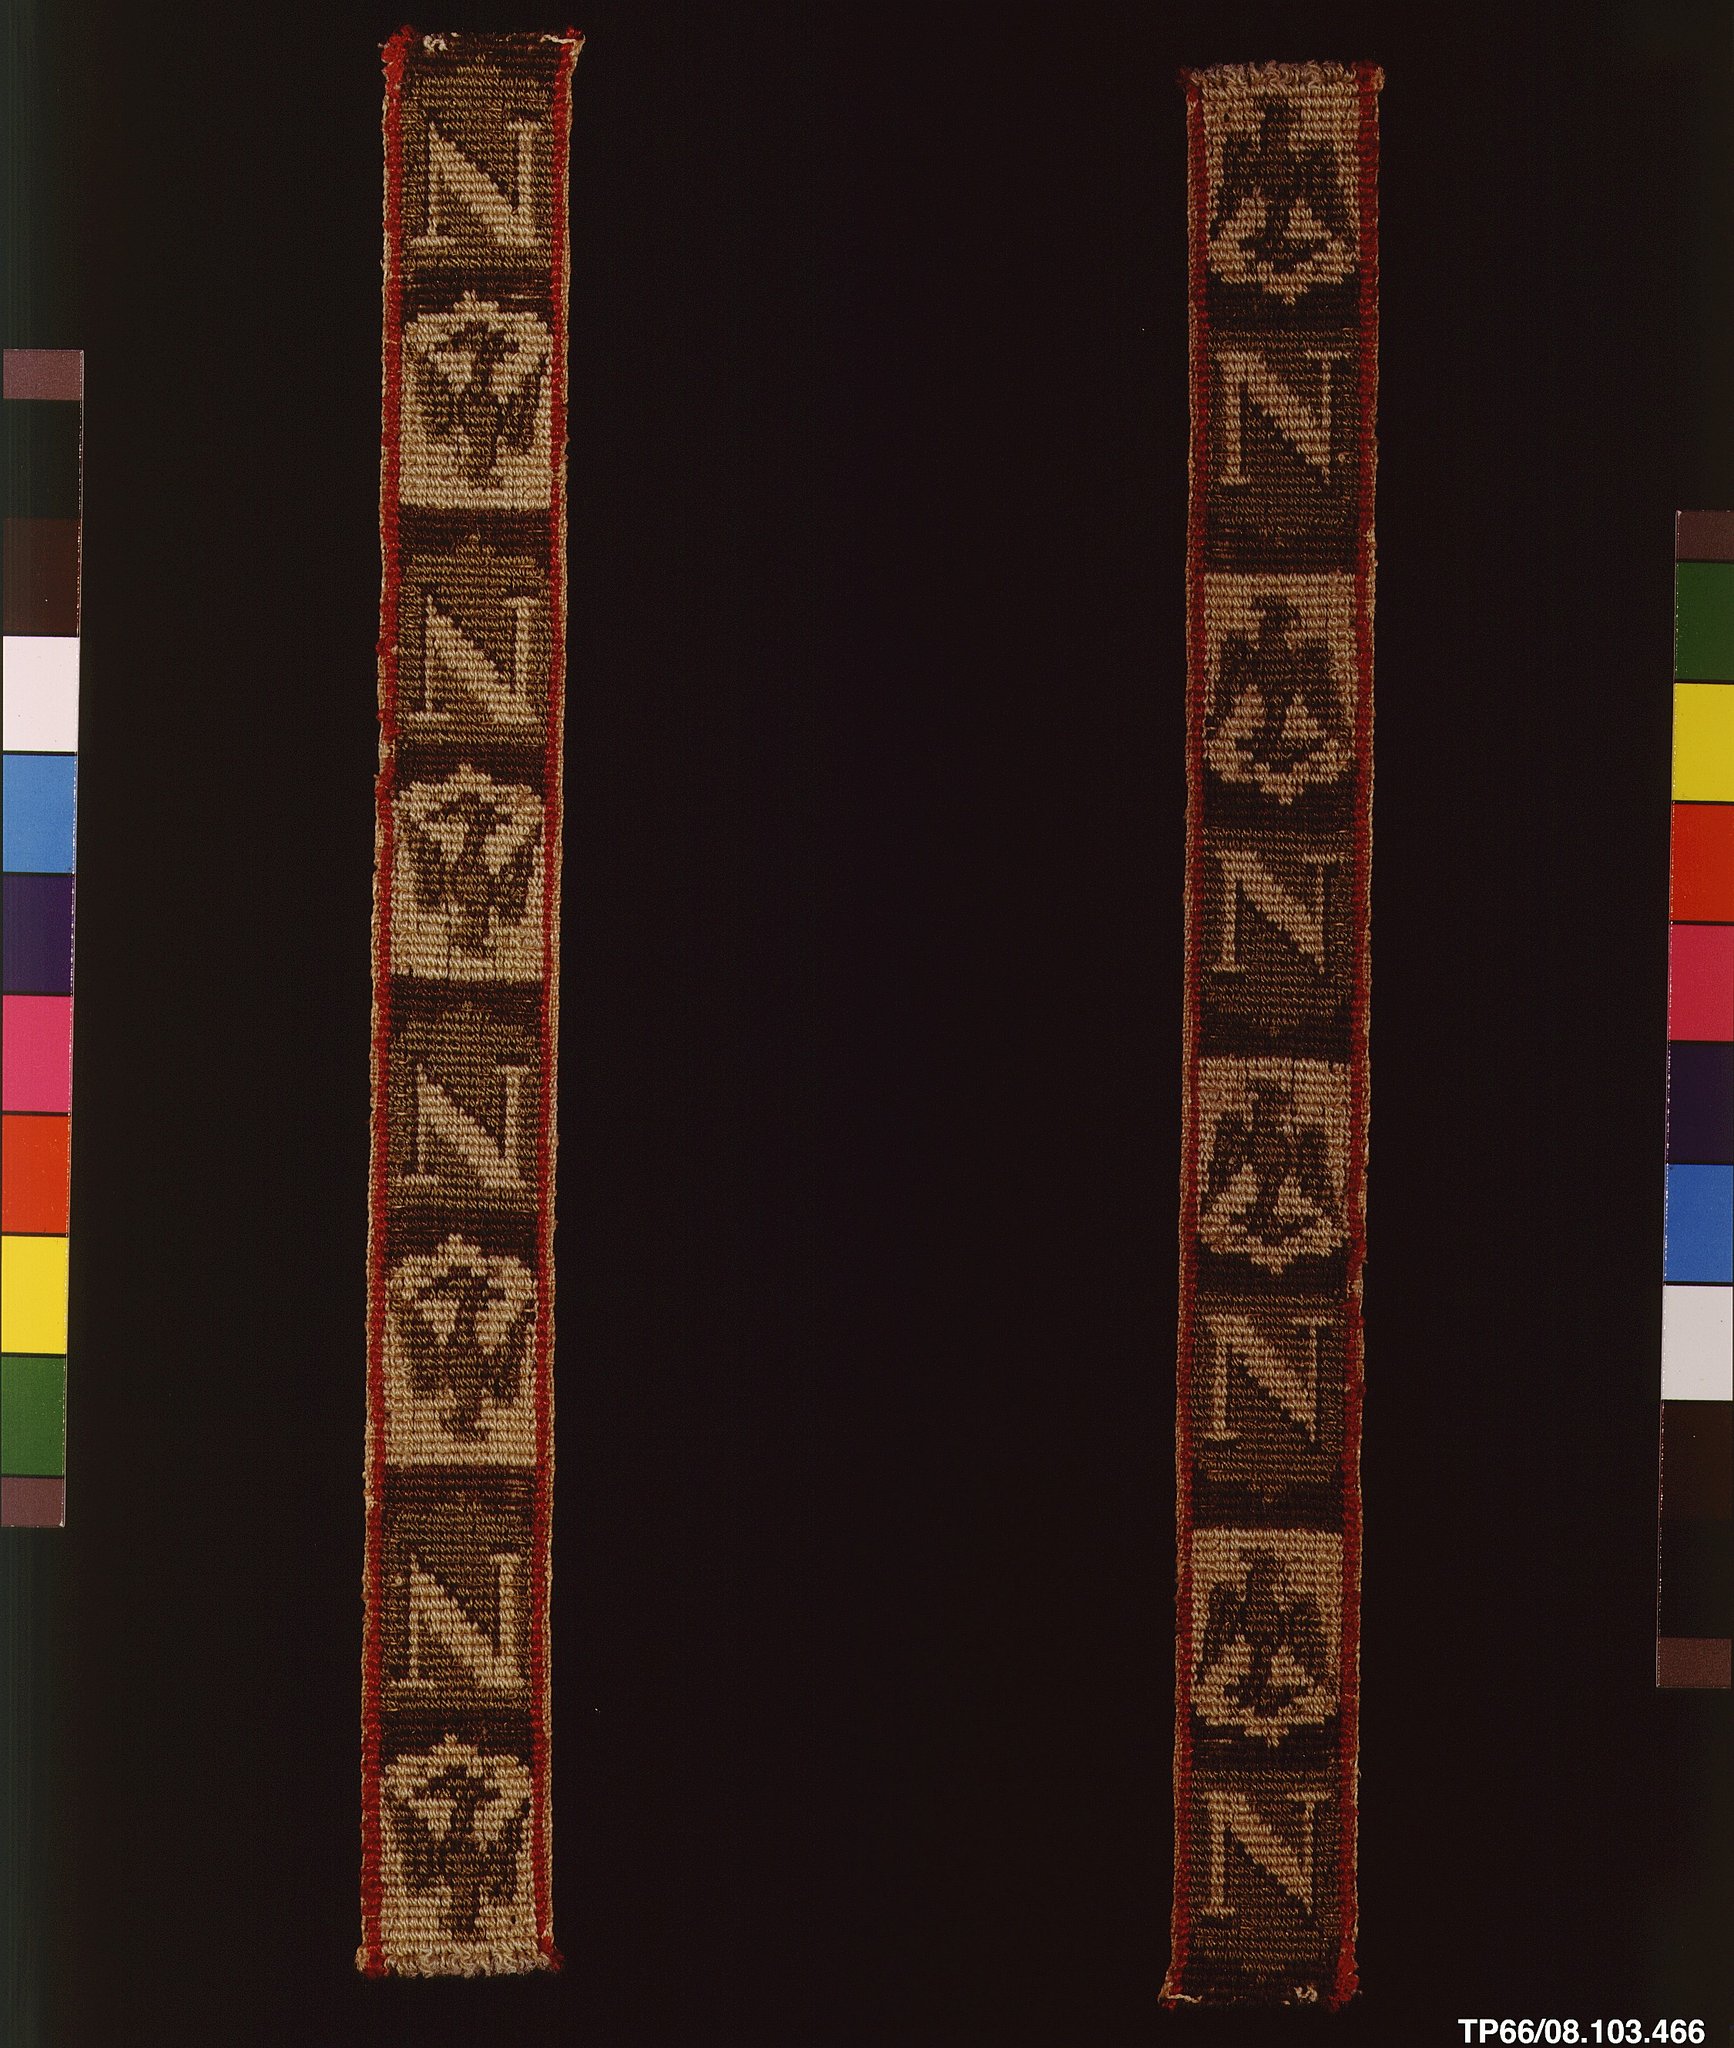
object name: galloon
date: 1801-1900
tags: birds